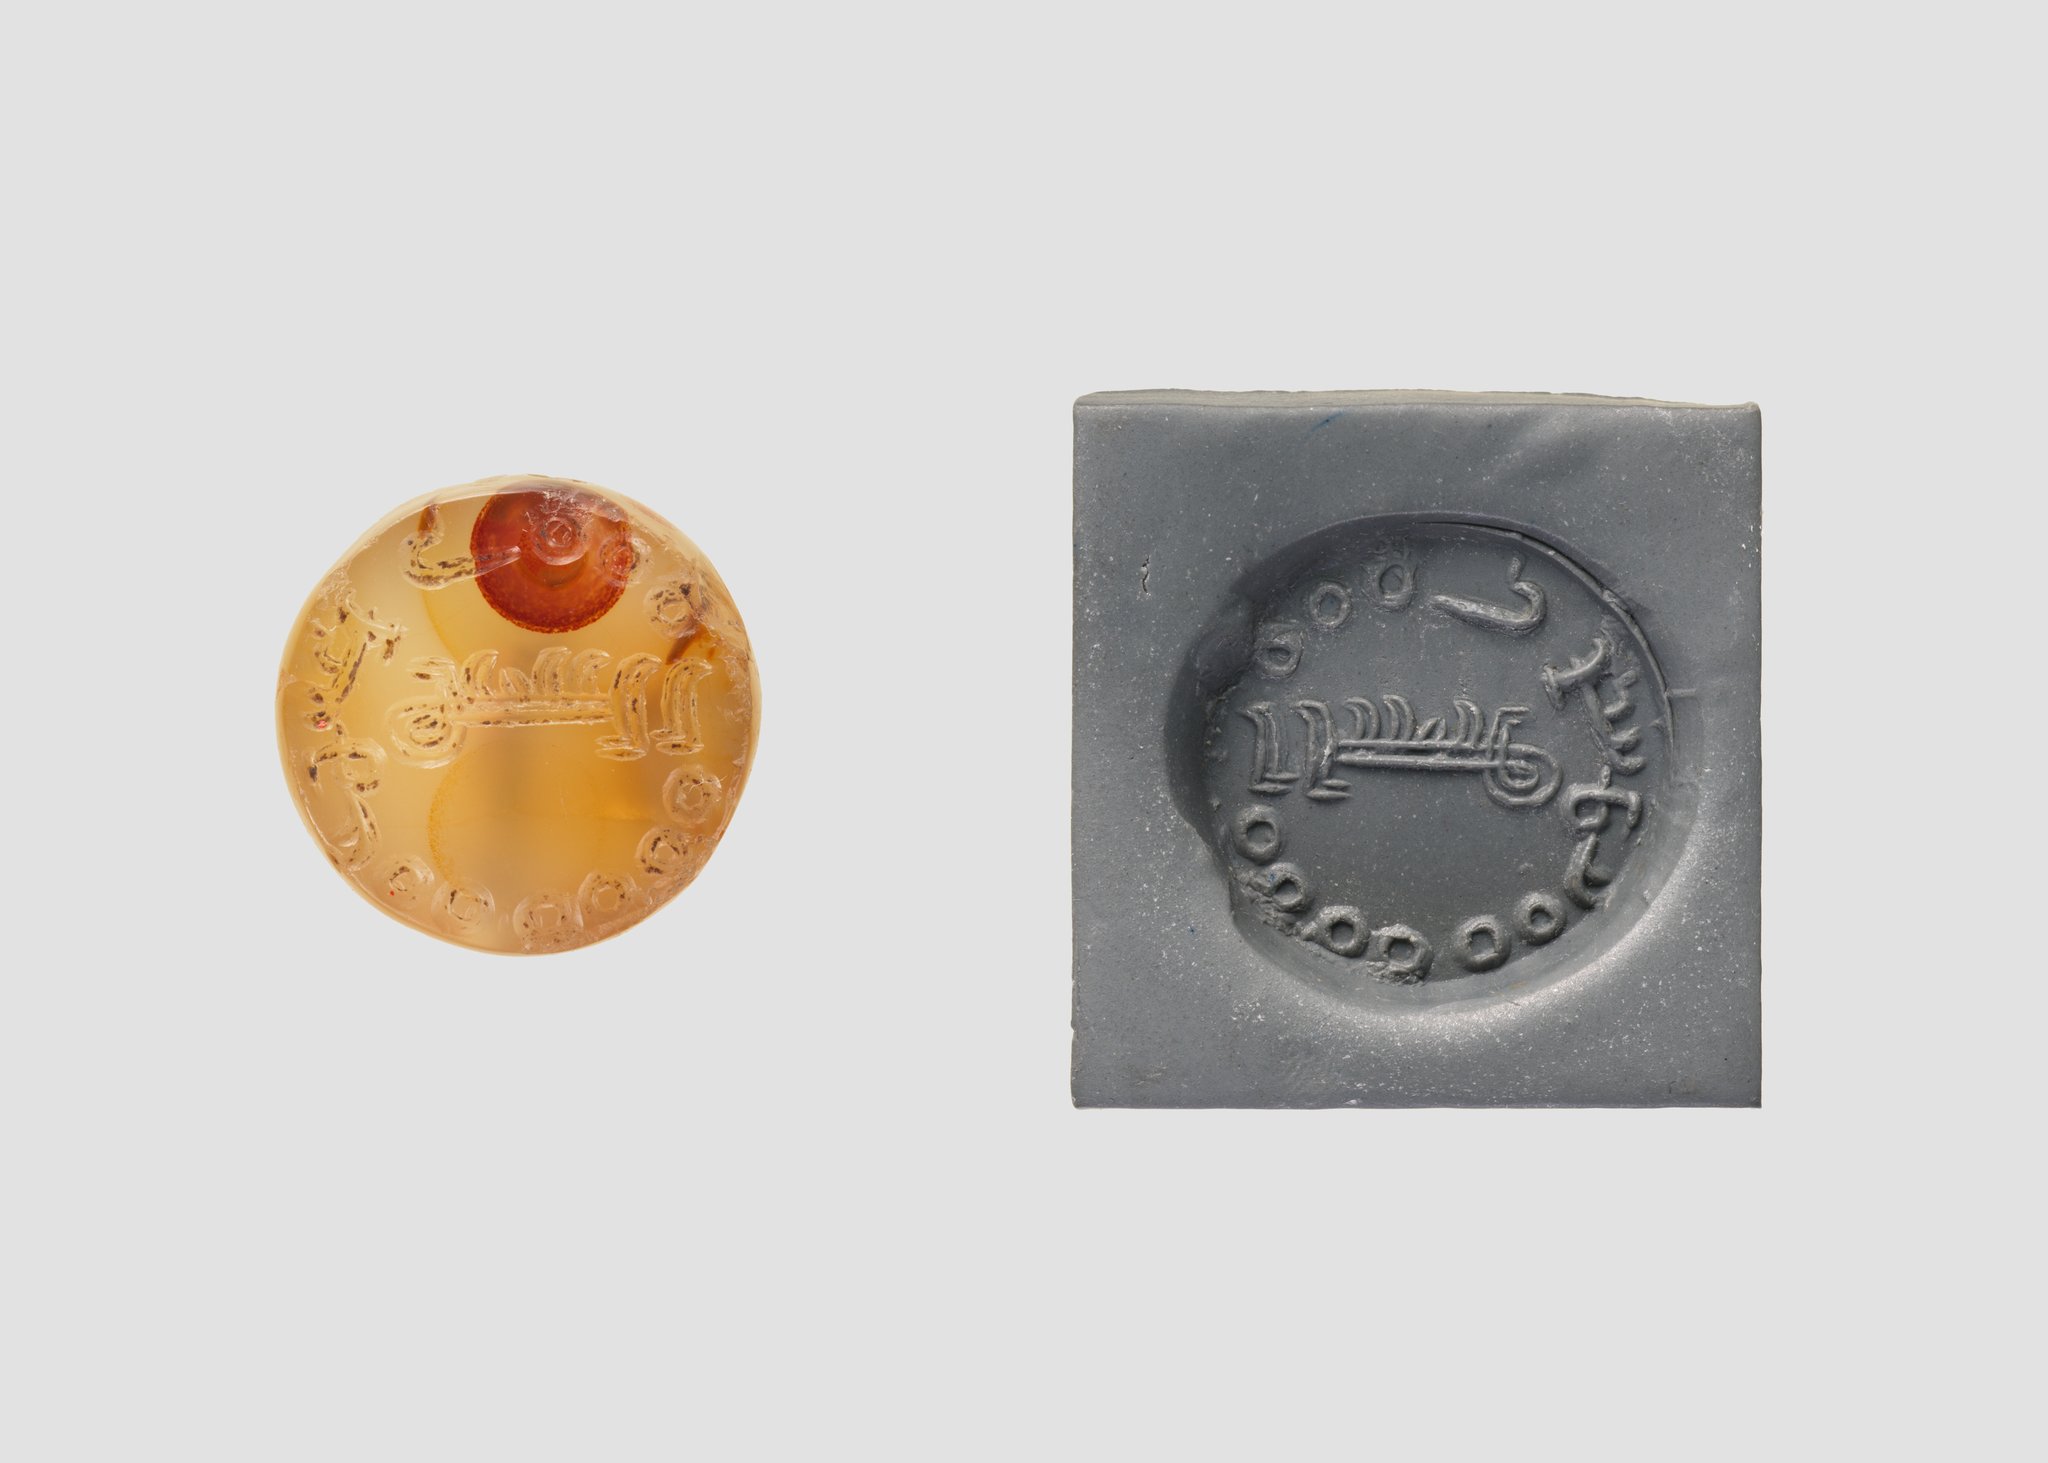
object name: stamp seal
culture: sasanian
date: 501-600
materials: stone, jasper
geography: iran or mesopotamia